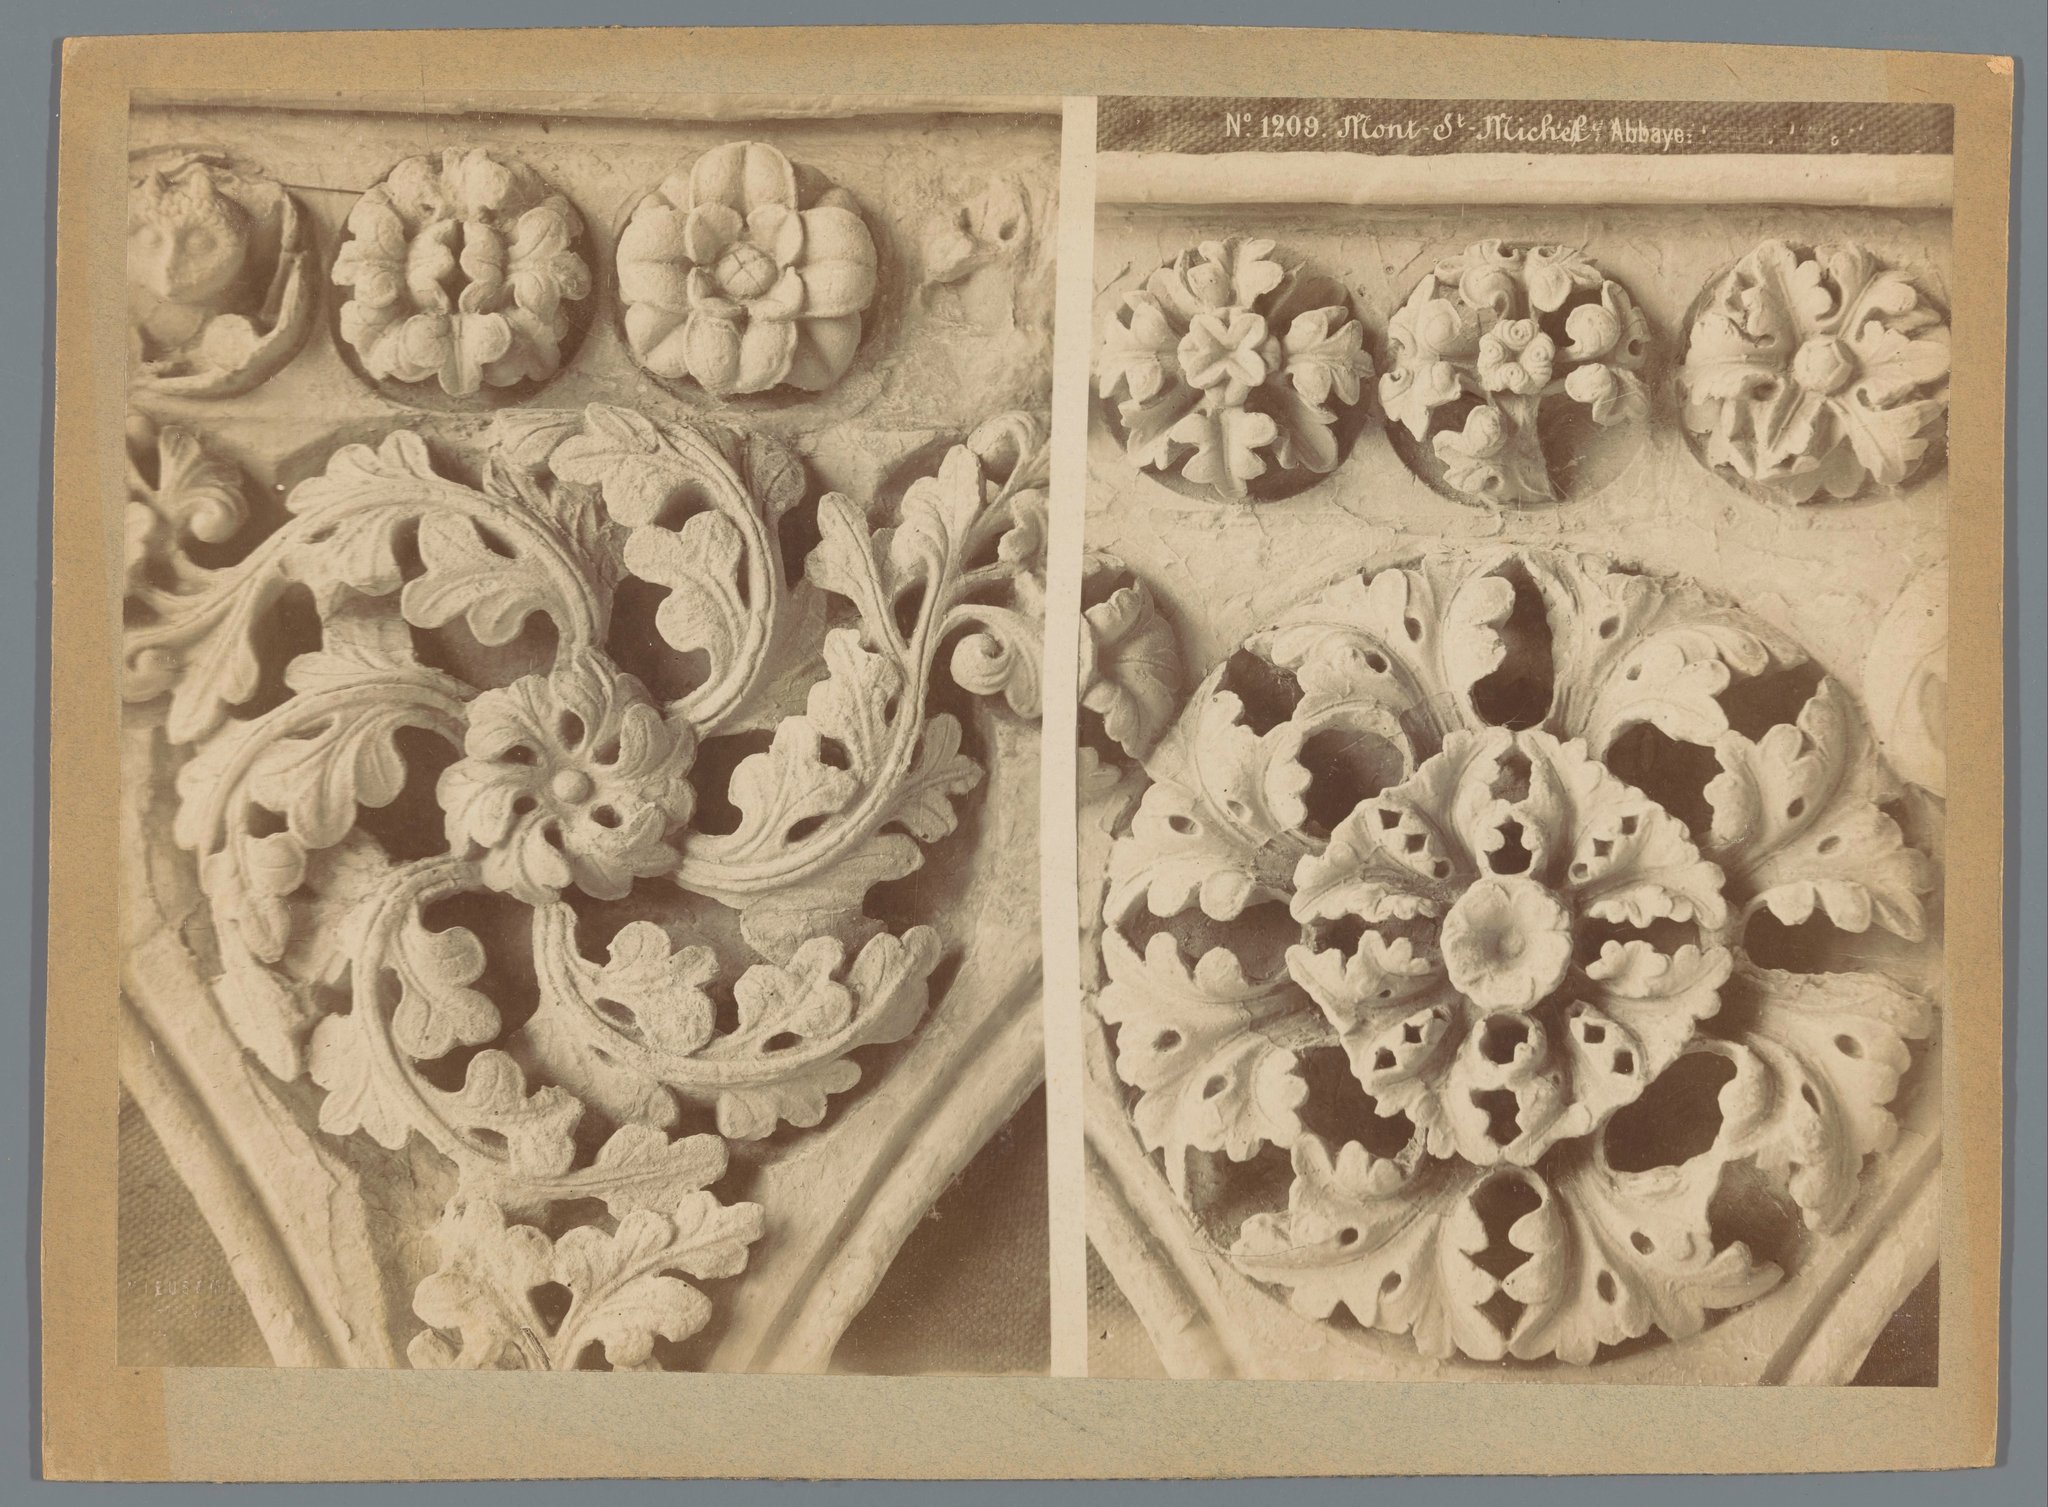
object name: photograph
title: Twee reliëfs met bloemmotieven in de abdij van Mont-Saint-Michel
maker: séraphin-médéric mieusement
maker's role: fotograaf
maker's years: 1840-1905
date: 1875-1900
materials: cardboard, photographic support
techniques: albumen print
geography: mont-saint-michel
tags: interior of church, flowers ~ ornament, sculpture (+ relief ~ sculpture)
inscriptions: inscription: ‘MONUMENTS HISTORIQUES’, number: ‘No. 1209.’, name: ‘MIEUSEMENT PHOTOGRAPHE’